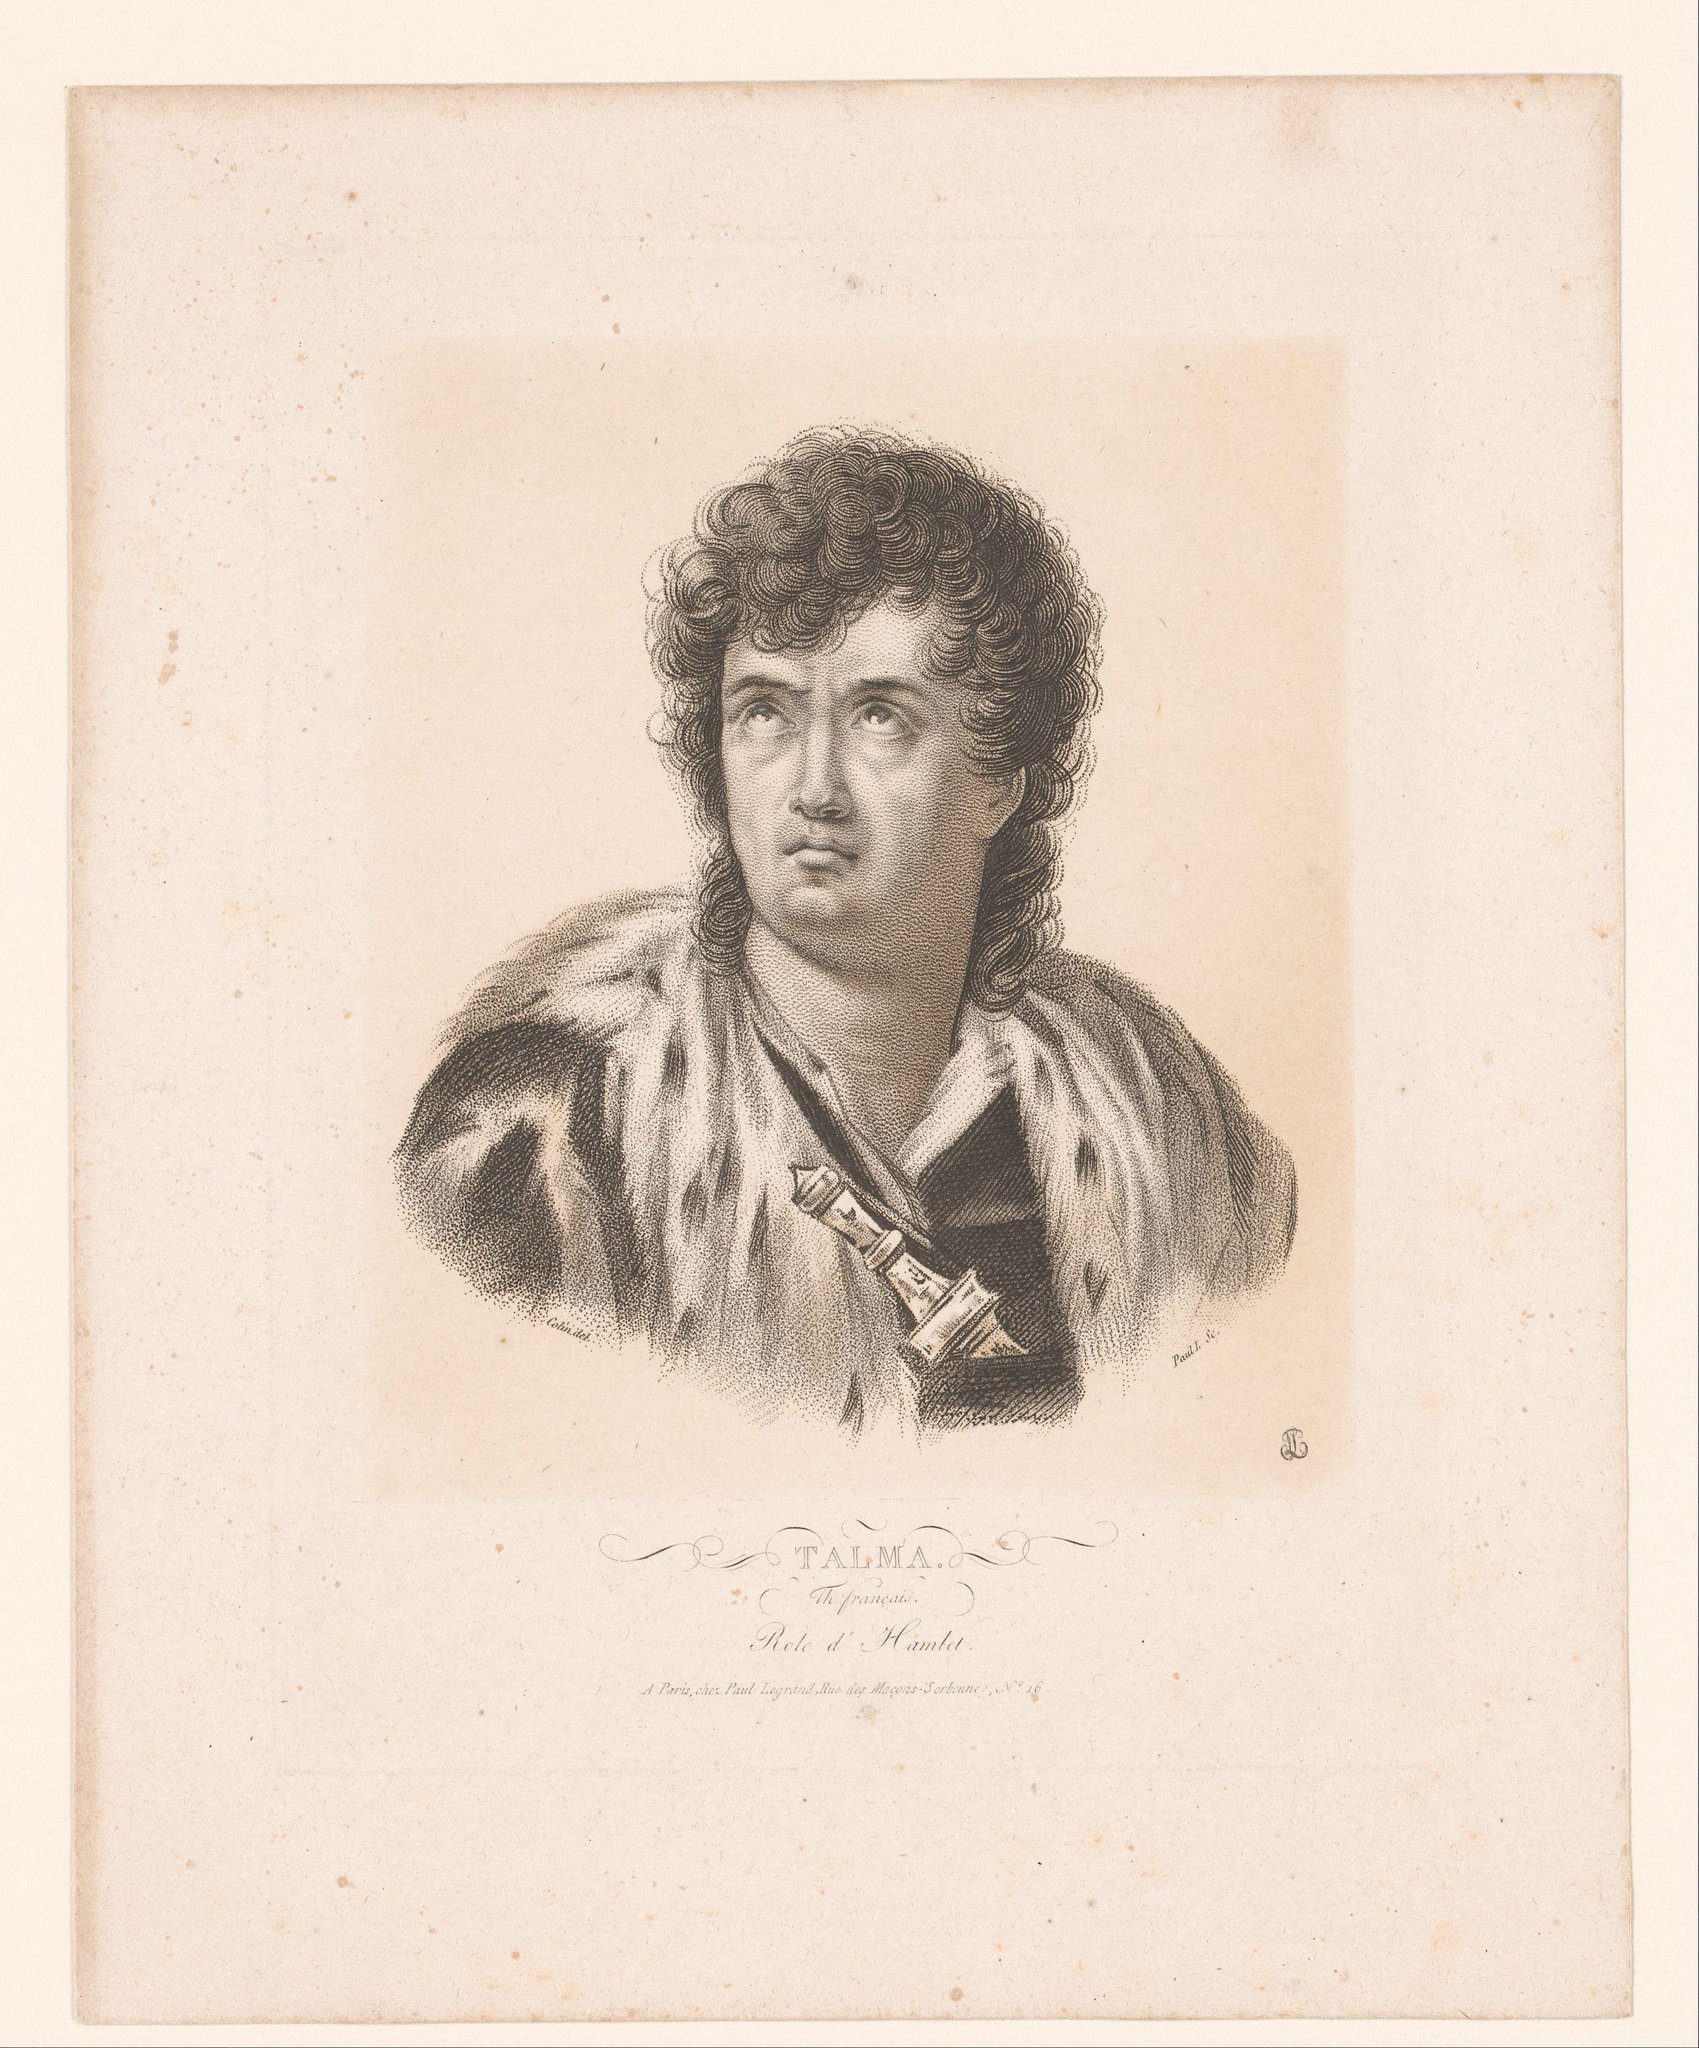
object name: print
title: Talma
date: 1820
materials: paper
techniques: engraving, etching, roulette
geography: paris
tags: paris, historical persons, portrait of actor, actress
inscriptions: collector's mark: Lugt 2228, collector's mark: Lugt 1756